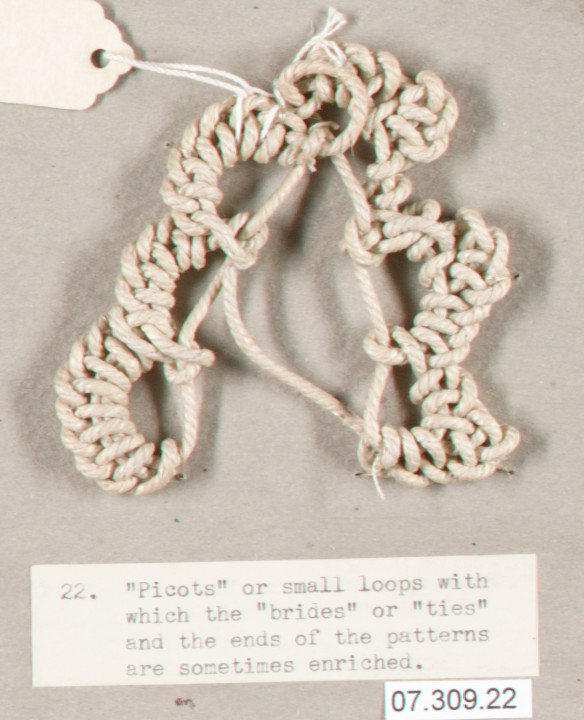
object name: stitch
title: Example of lace stitch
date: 1801-2000